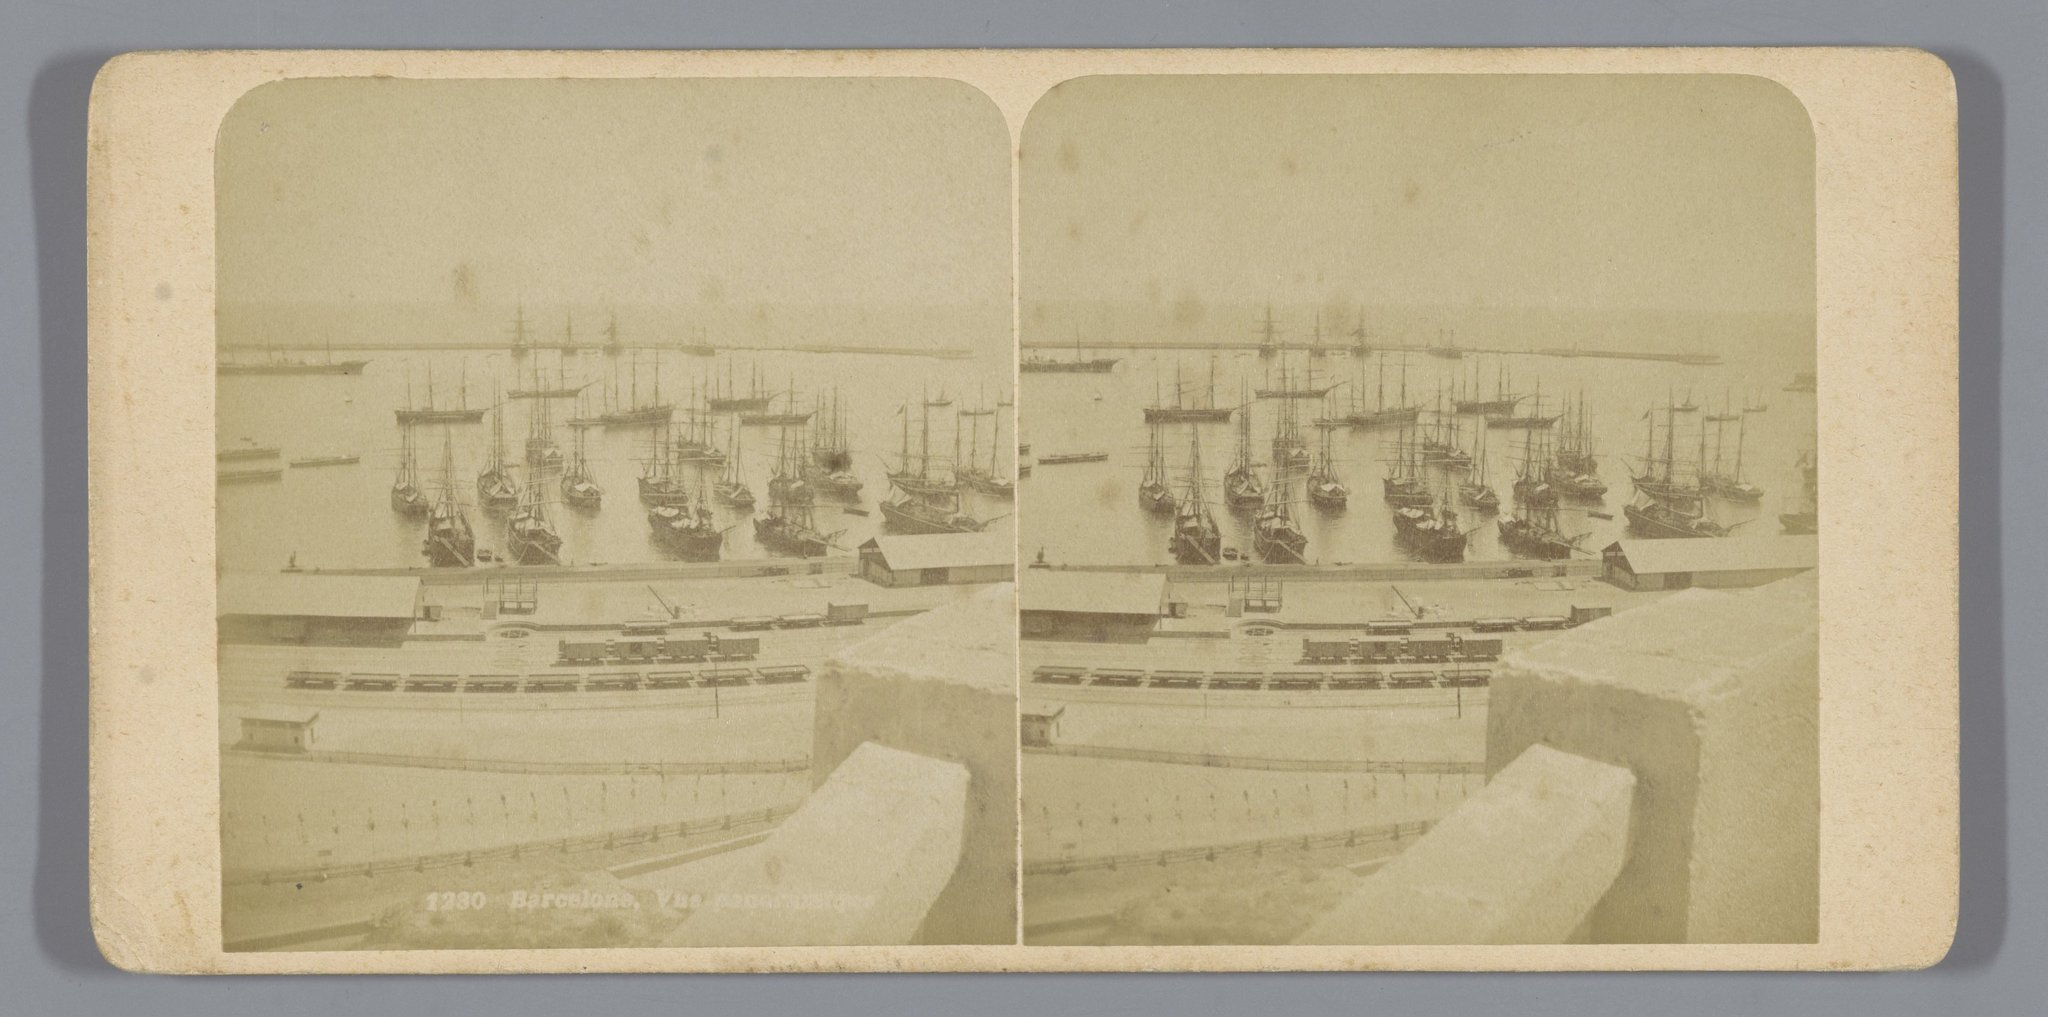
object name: stereograph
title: Gezicht op de haven van Barcelona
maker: Anonymous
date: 1850-1880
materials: cardboard, photographic support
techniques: albumen print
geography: amsterdam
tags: harbour, ships (in general) - cc - more than one ship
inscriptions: inscription: ‘Aardrijkskundige Beeldengalerij (...) Op de kade goederenloodsen, waggons, kranen, enz.’, number: ‘19.’, number: ‘1230’